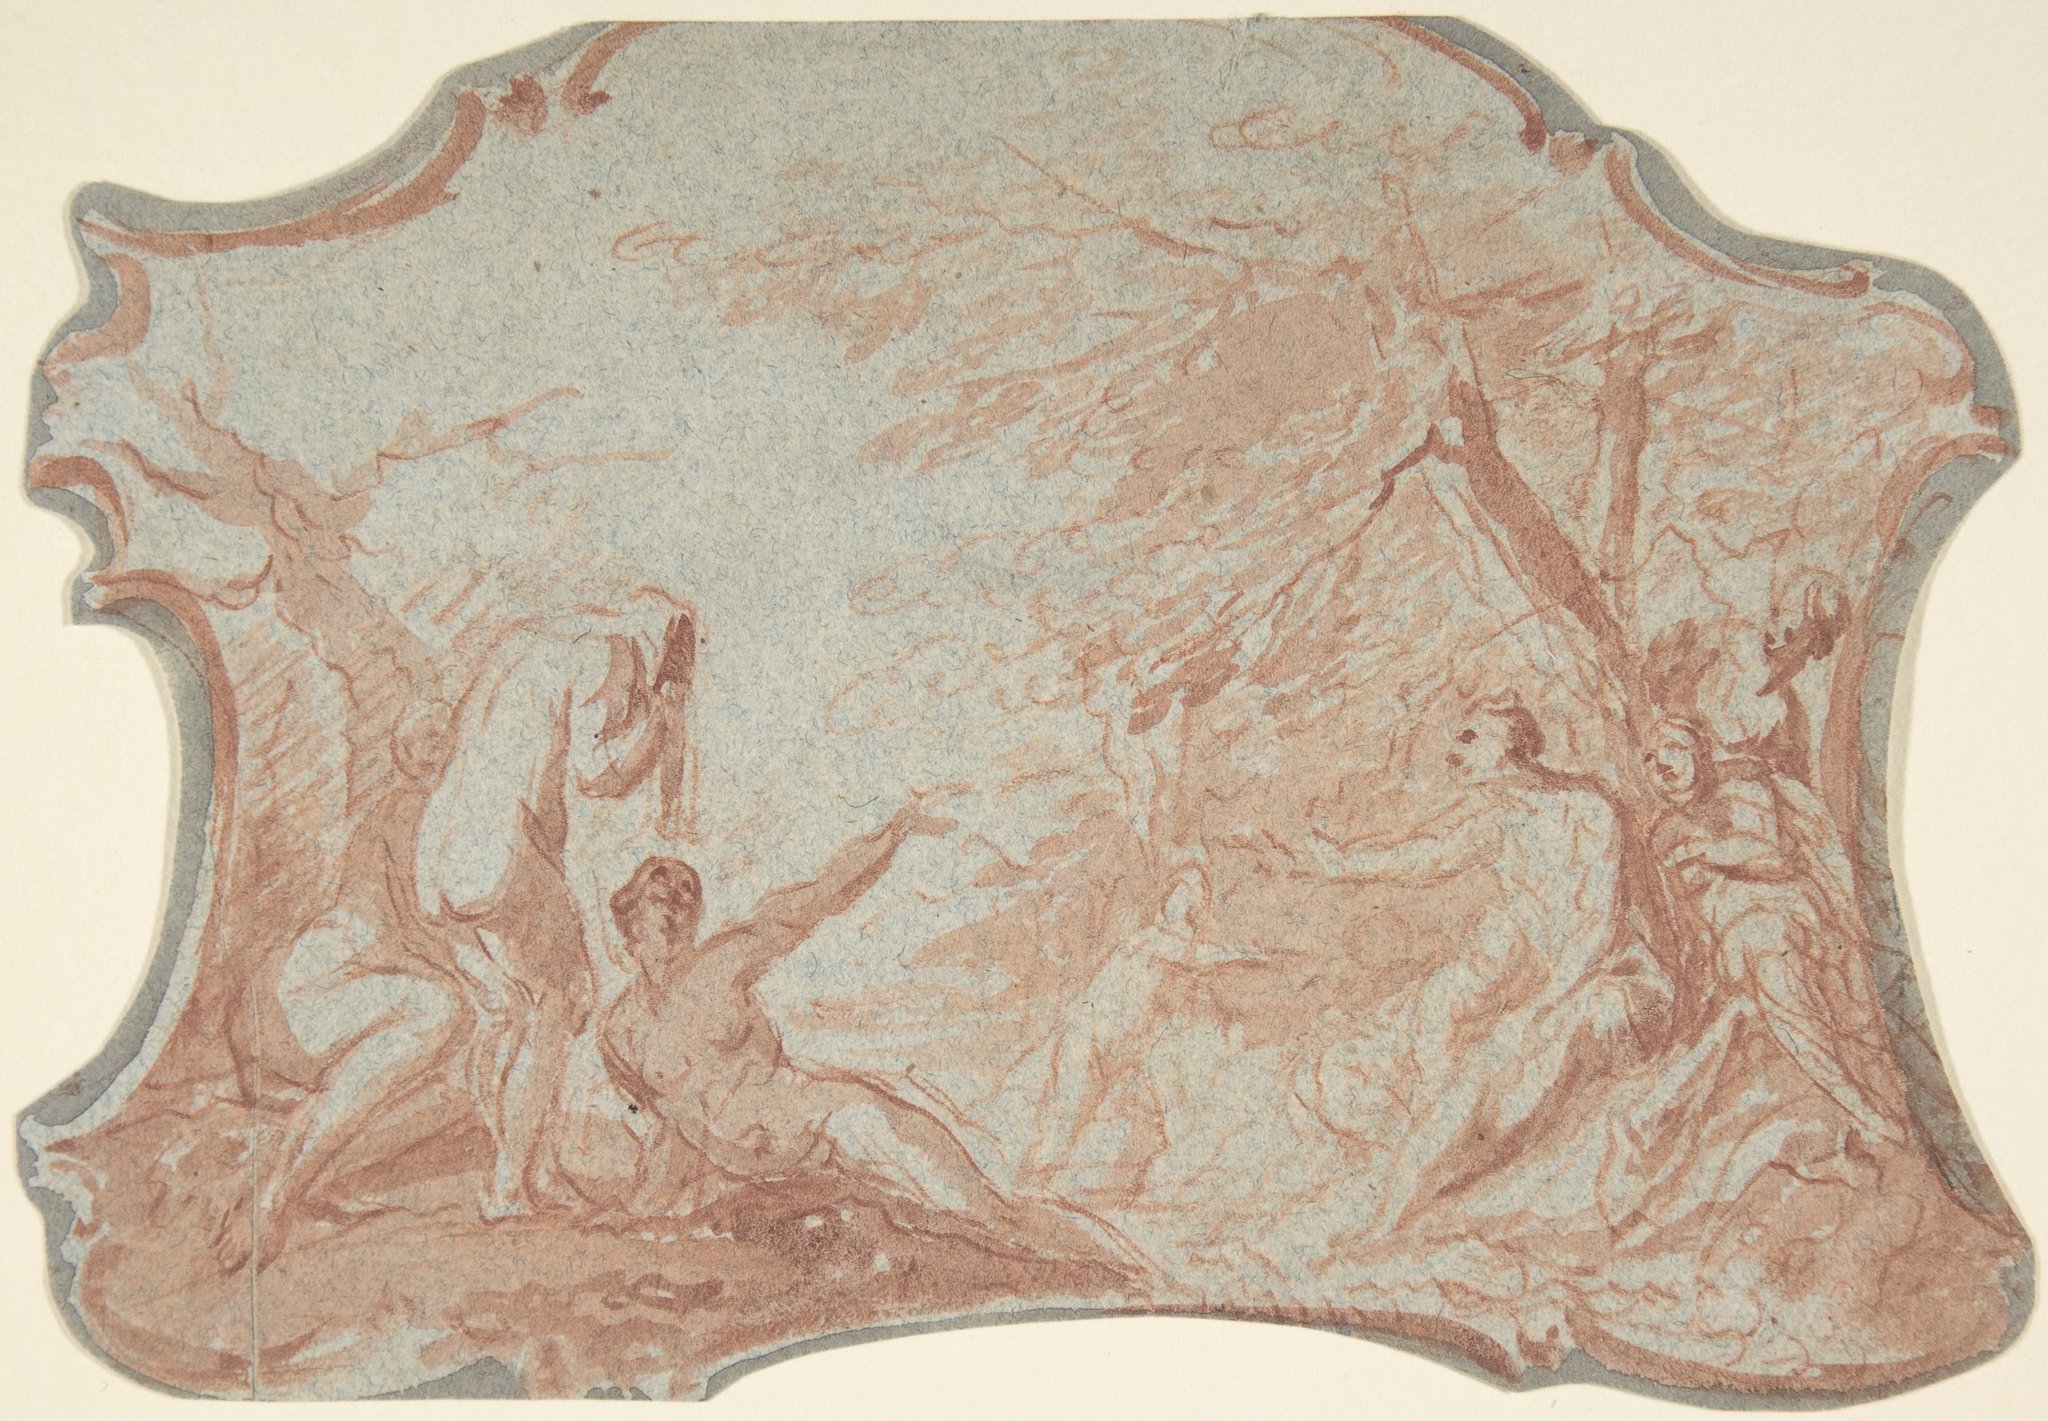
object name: drawing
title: Diana and Callisto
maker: philipp hieronymus brinckmann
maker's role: artist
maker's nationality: german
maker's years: 1709-1761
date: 1725-1761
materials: chalk, paper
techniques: wash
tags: diana